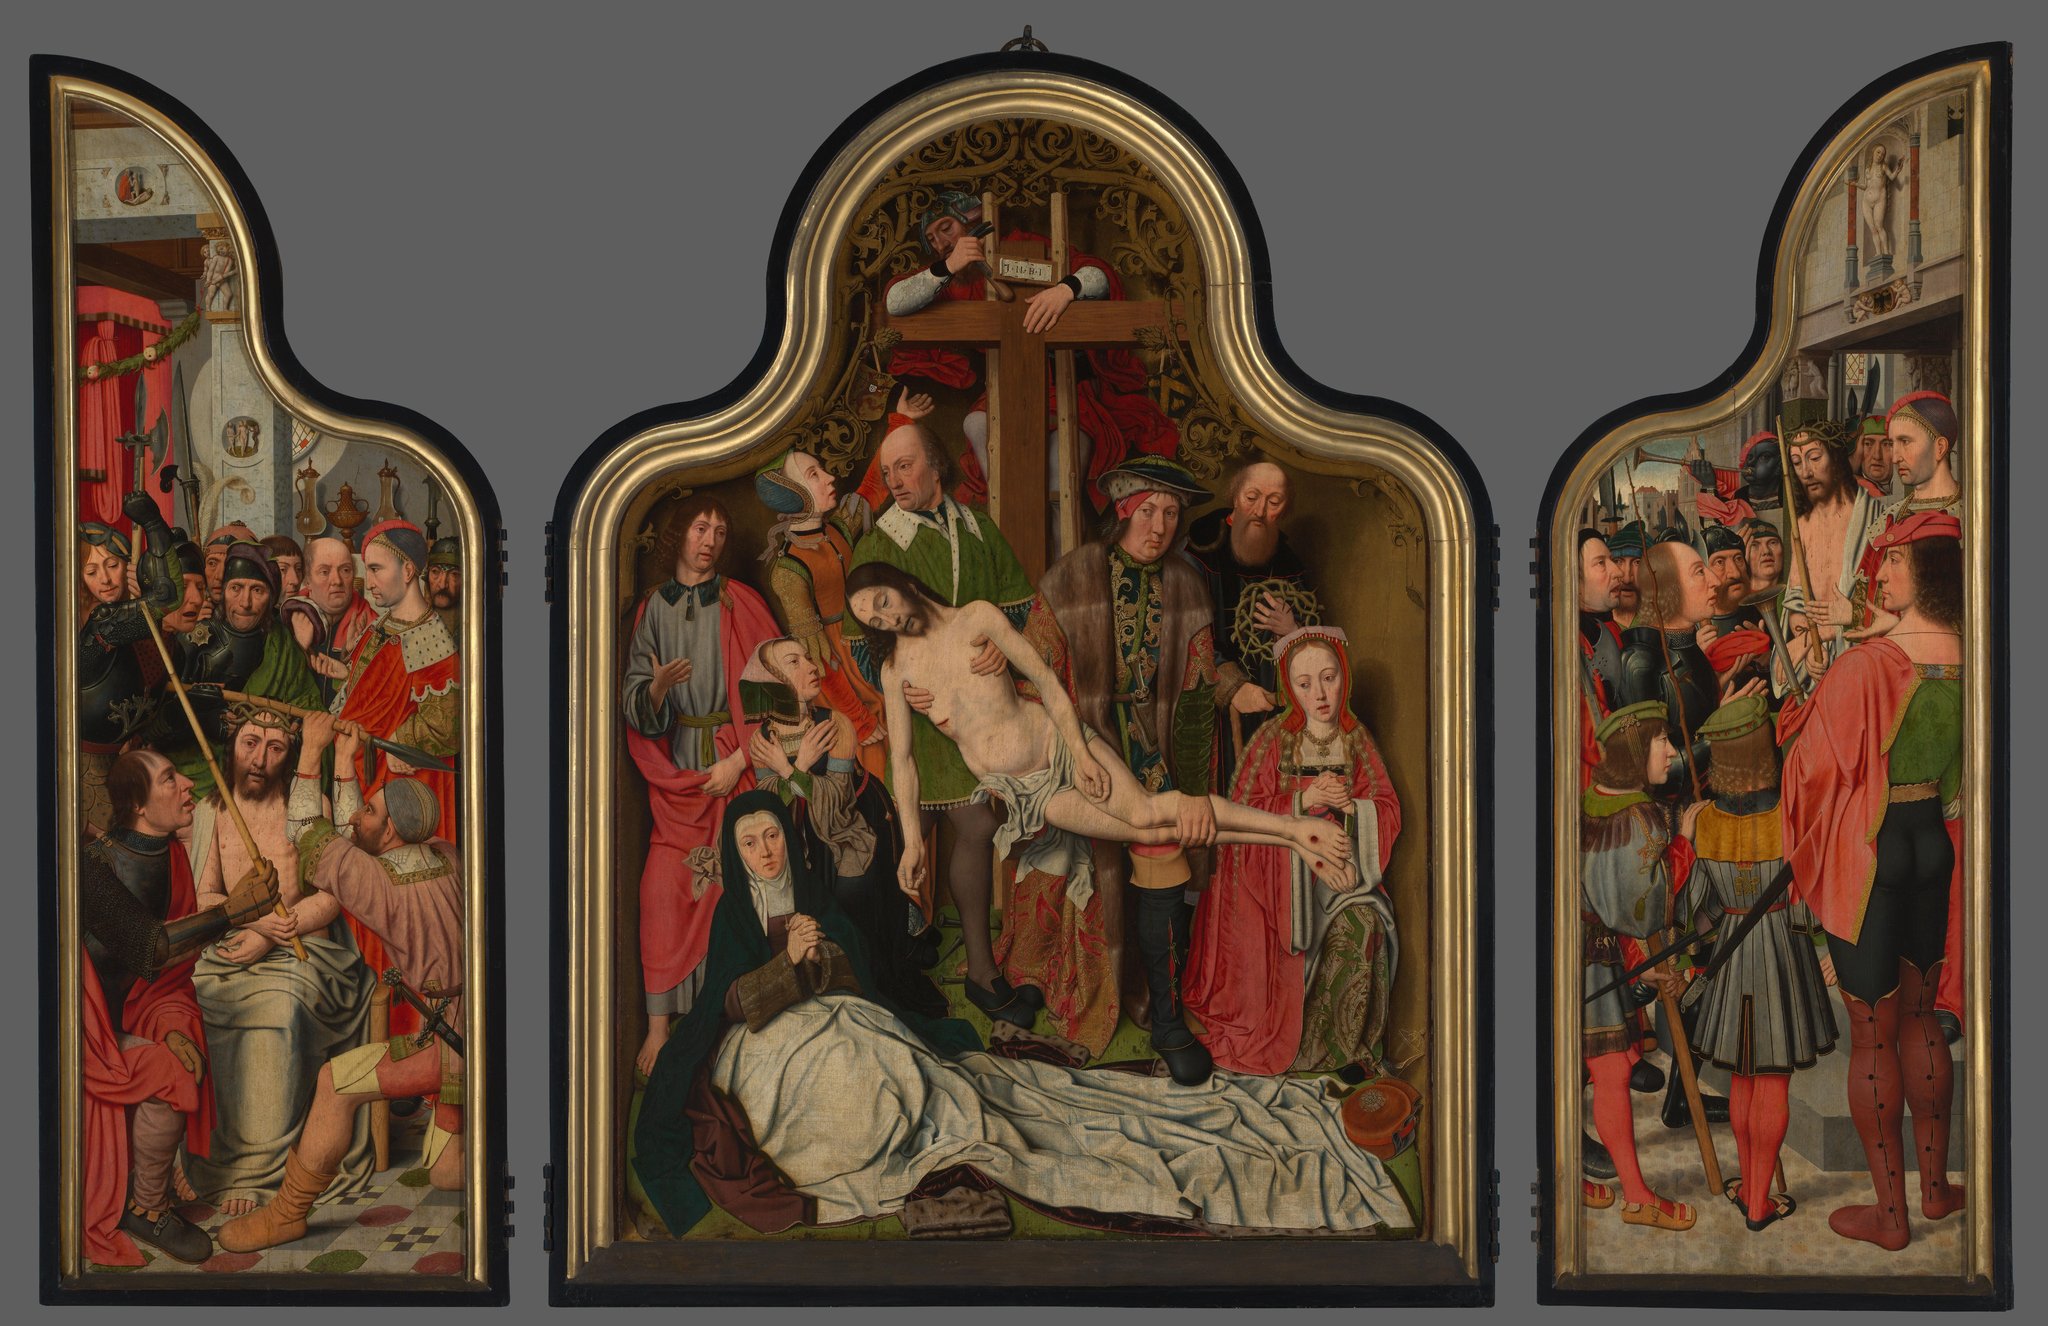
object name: painting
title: Passietriptiek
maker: jan jansz mostaert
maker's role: draughtsman, painter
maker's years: 1465-1553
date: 1515-1520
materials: oil, paint, panel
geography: haarlem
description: Kruisafneming op het middenpaneel, de Doornenkroning op het linkerpaneel en Ecce Homo op het rechterpaneel. De buitenzijden van het linker- en rechterpaneel tonen de Kruisdraging als onderdeel van de Beklimming van Golgotha. Rechts vooraan knielt Albrecht Adriaensz. van Adrichem voor Christus, aanbevolen door de heilige Catharina en de heilige Bavo. Links houdt de heilige Veronica de zweetdoek met het gelaat van Jezus.